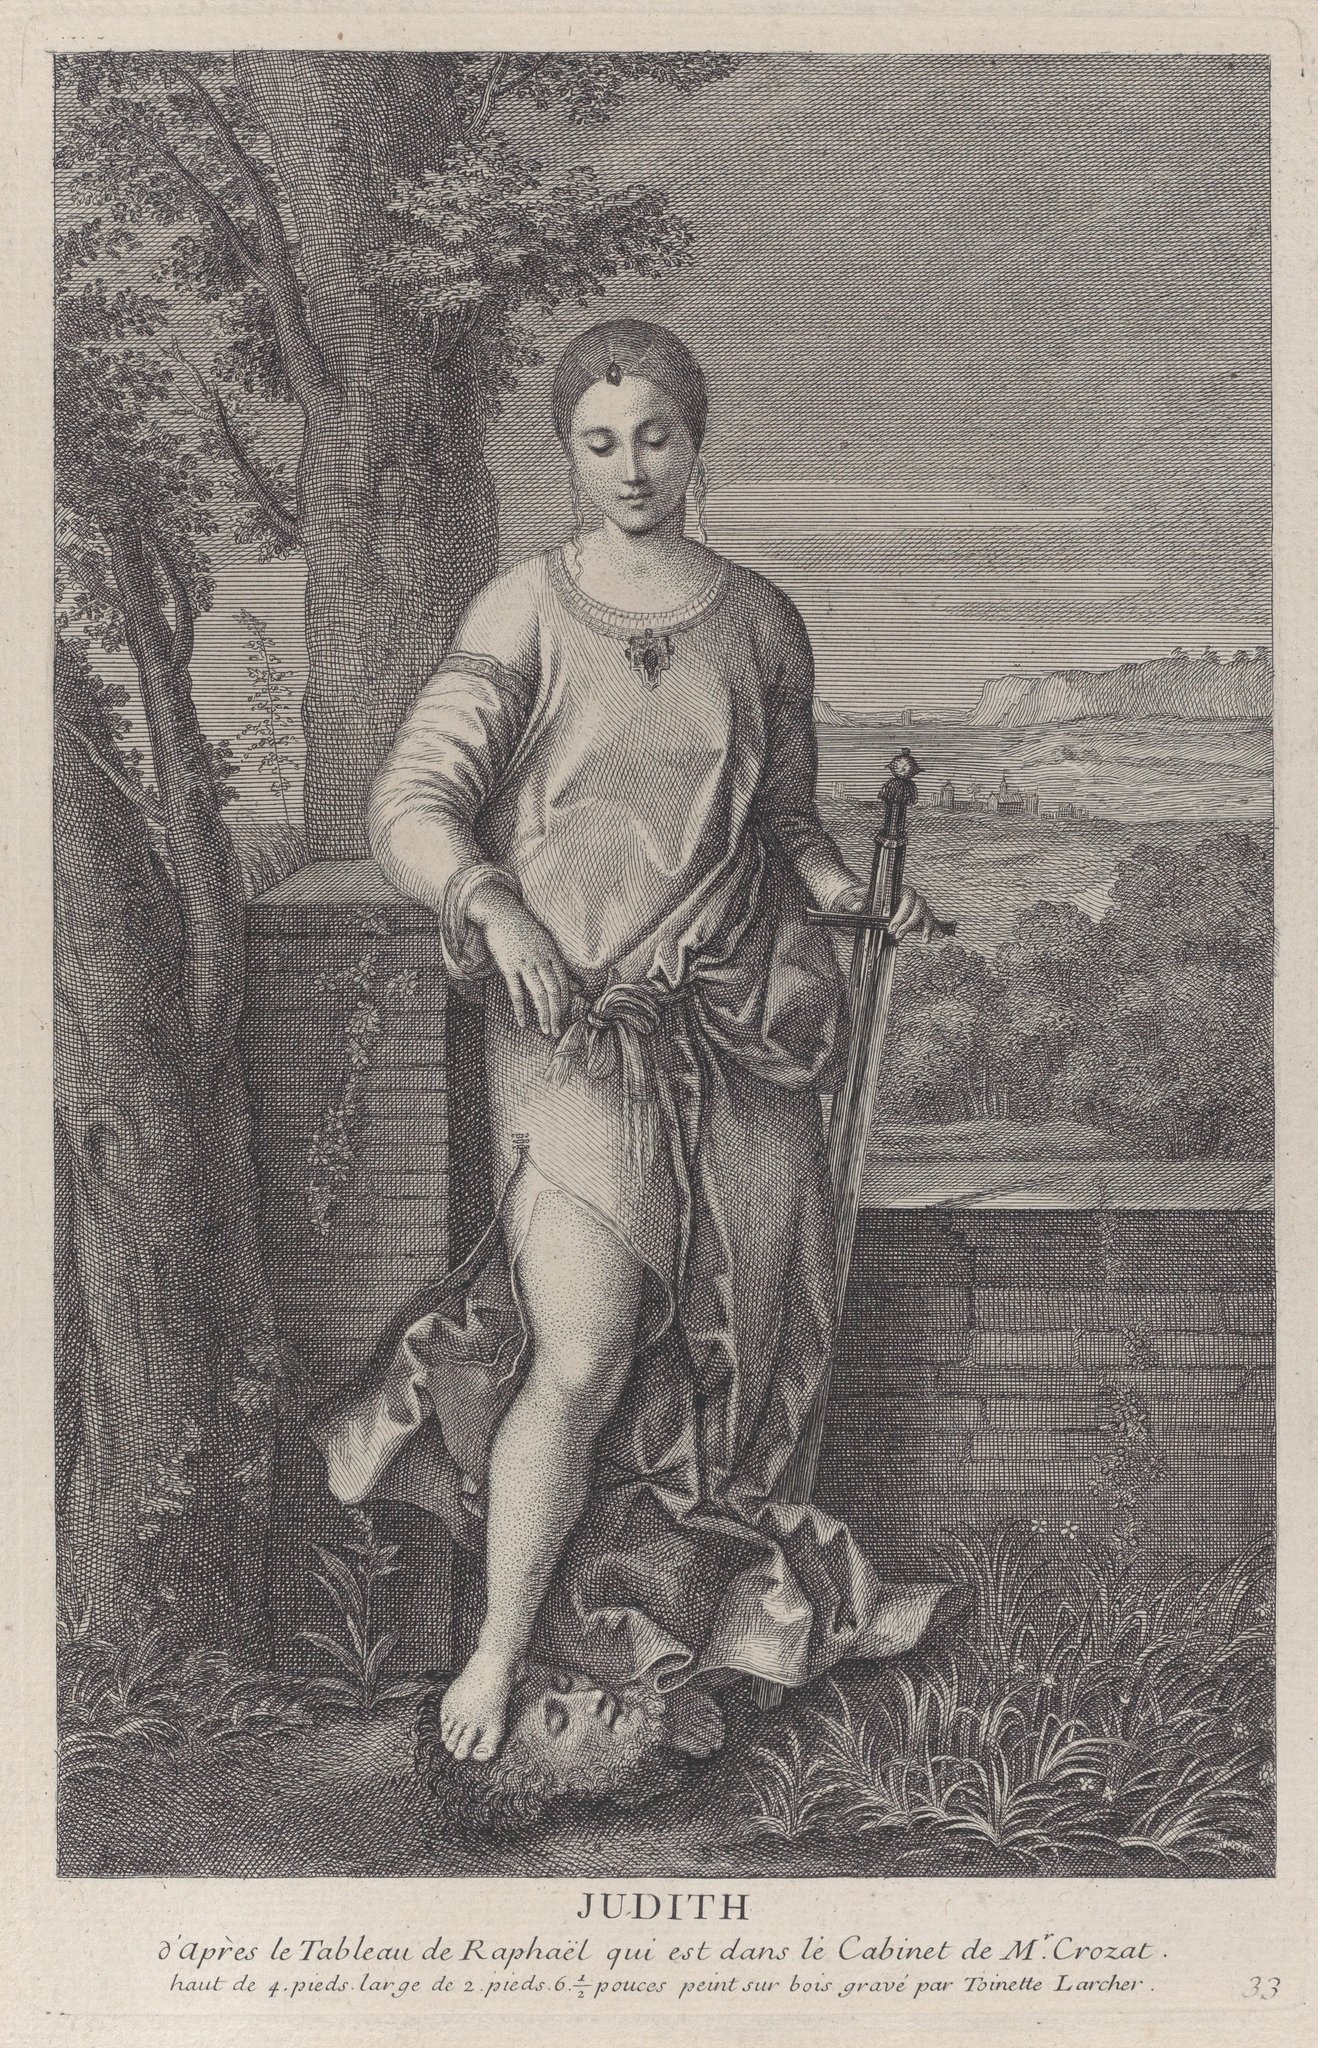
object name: print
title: Judith standing with her foot on the head of Holofernes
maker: antoinette larcher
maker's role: artist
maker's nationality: french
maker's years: 1685-1785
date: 1729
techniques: engraving, etching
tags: women,holofernes,judith